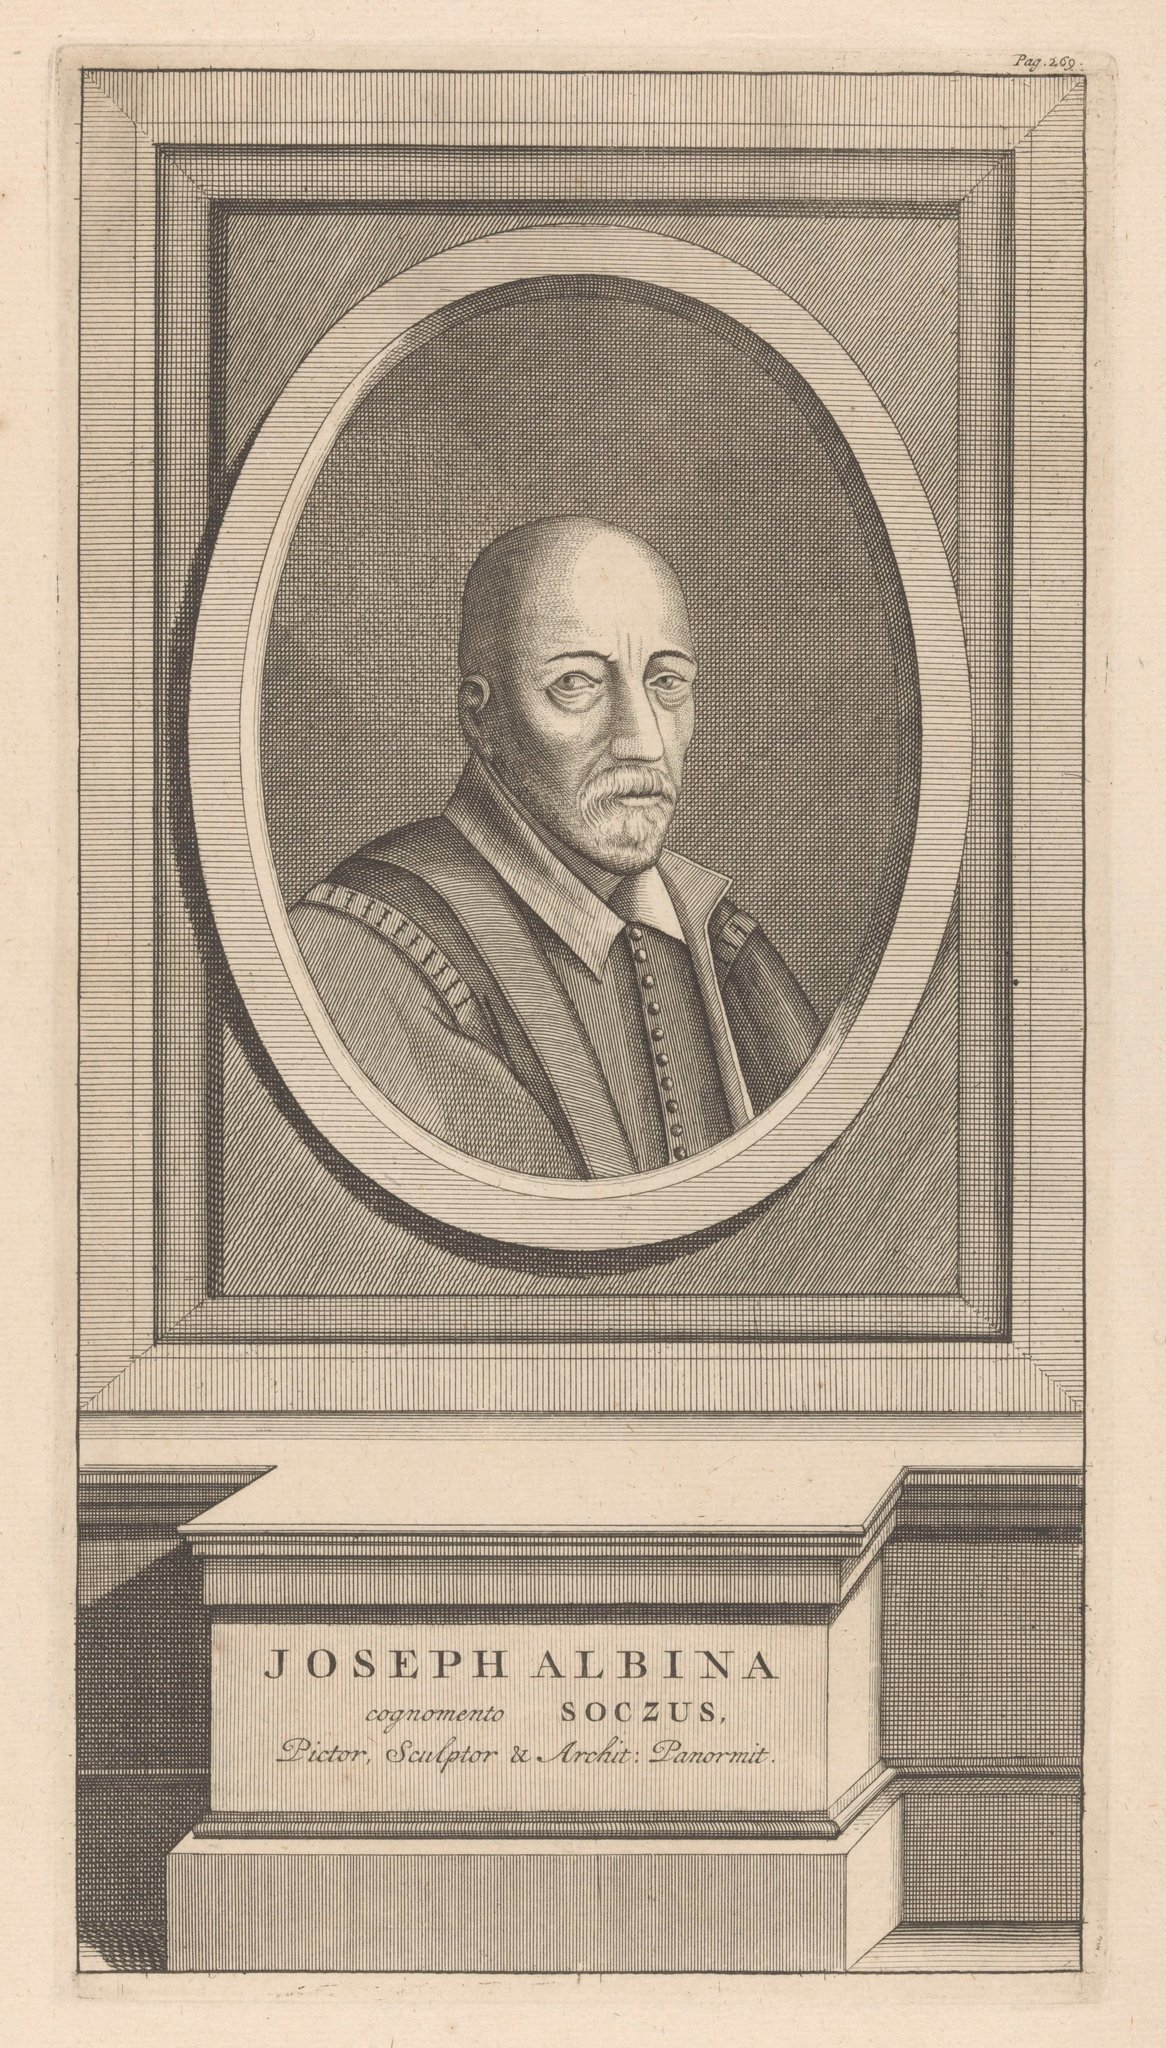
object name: print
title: Portret van Giuseppe d’Alvino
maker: Anonymous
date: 1600-1699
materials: paper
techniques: engraving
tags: painter, sculptor, giuseppe d’ alvino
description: Portret van Giuseppe d’Alvino in een ovale omlijsting. In een kader zijn namen en beroepen. Rechtsboven: Pag. 269.